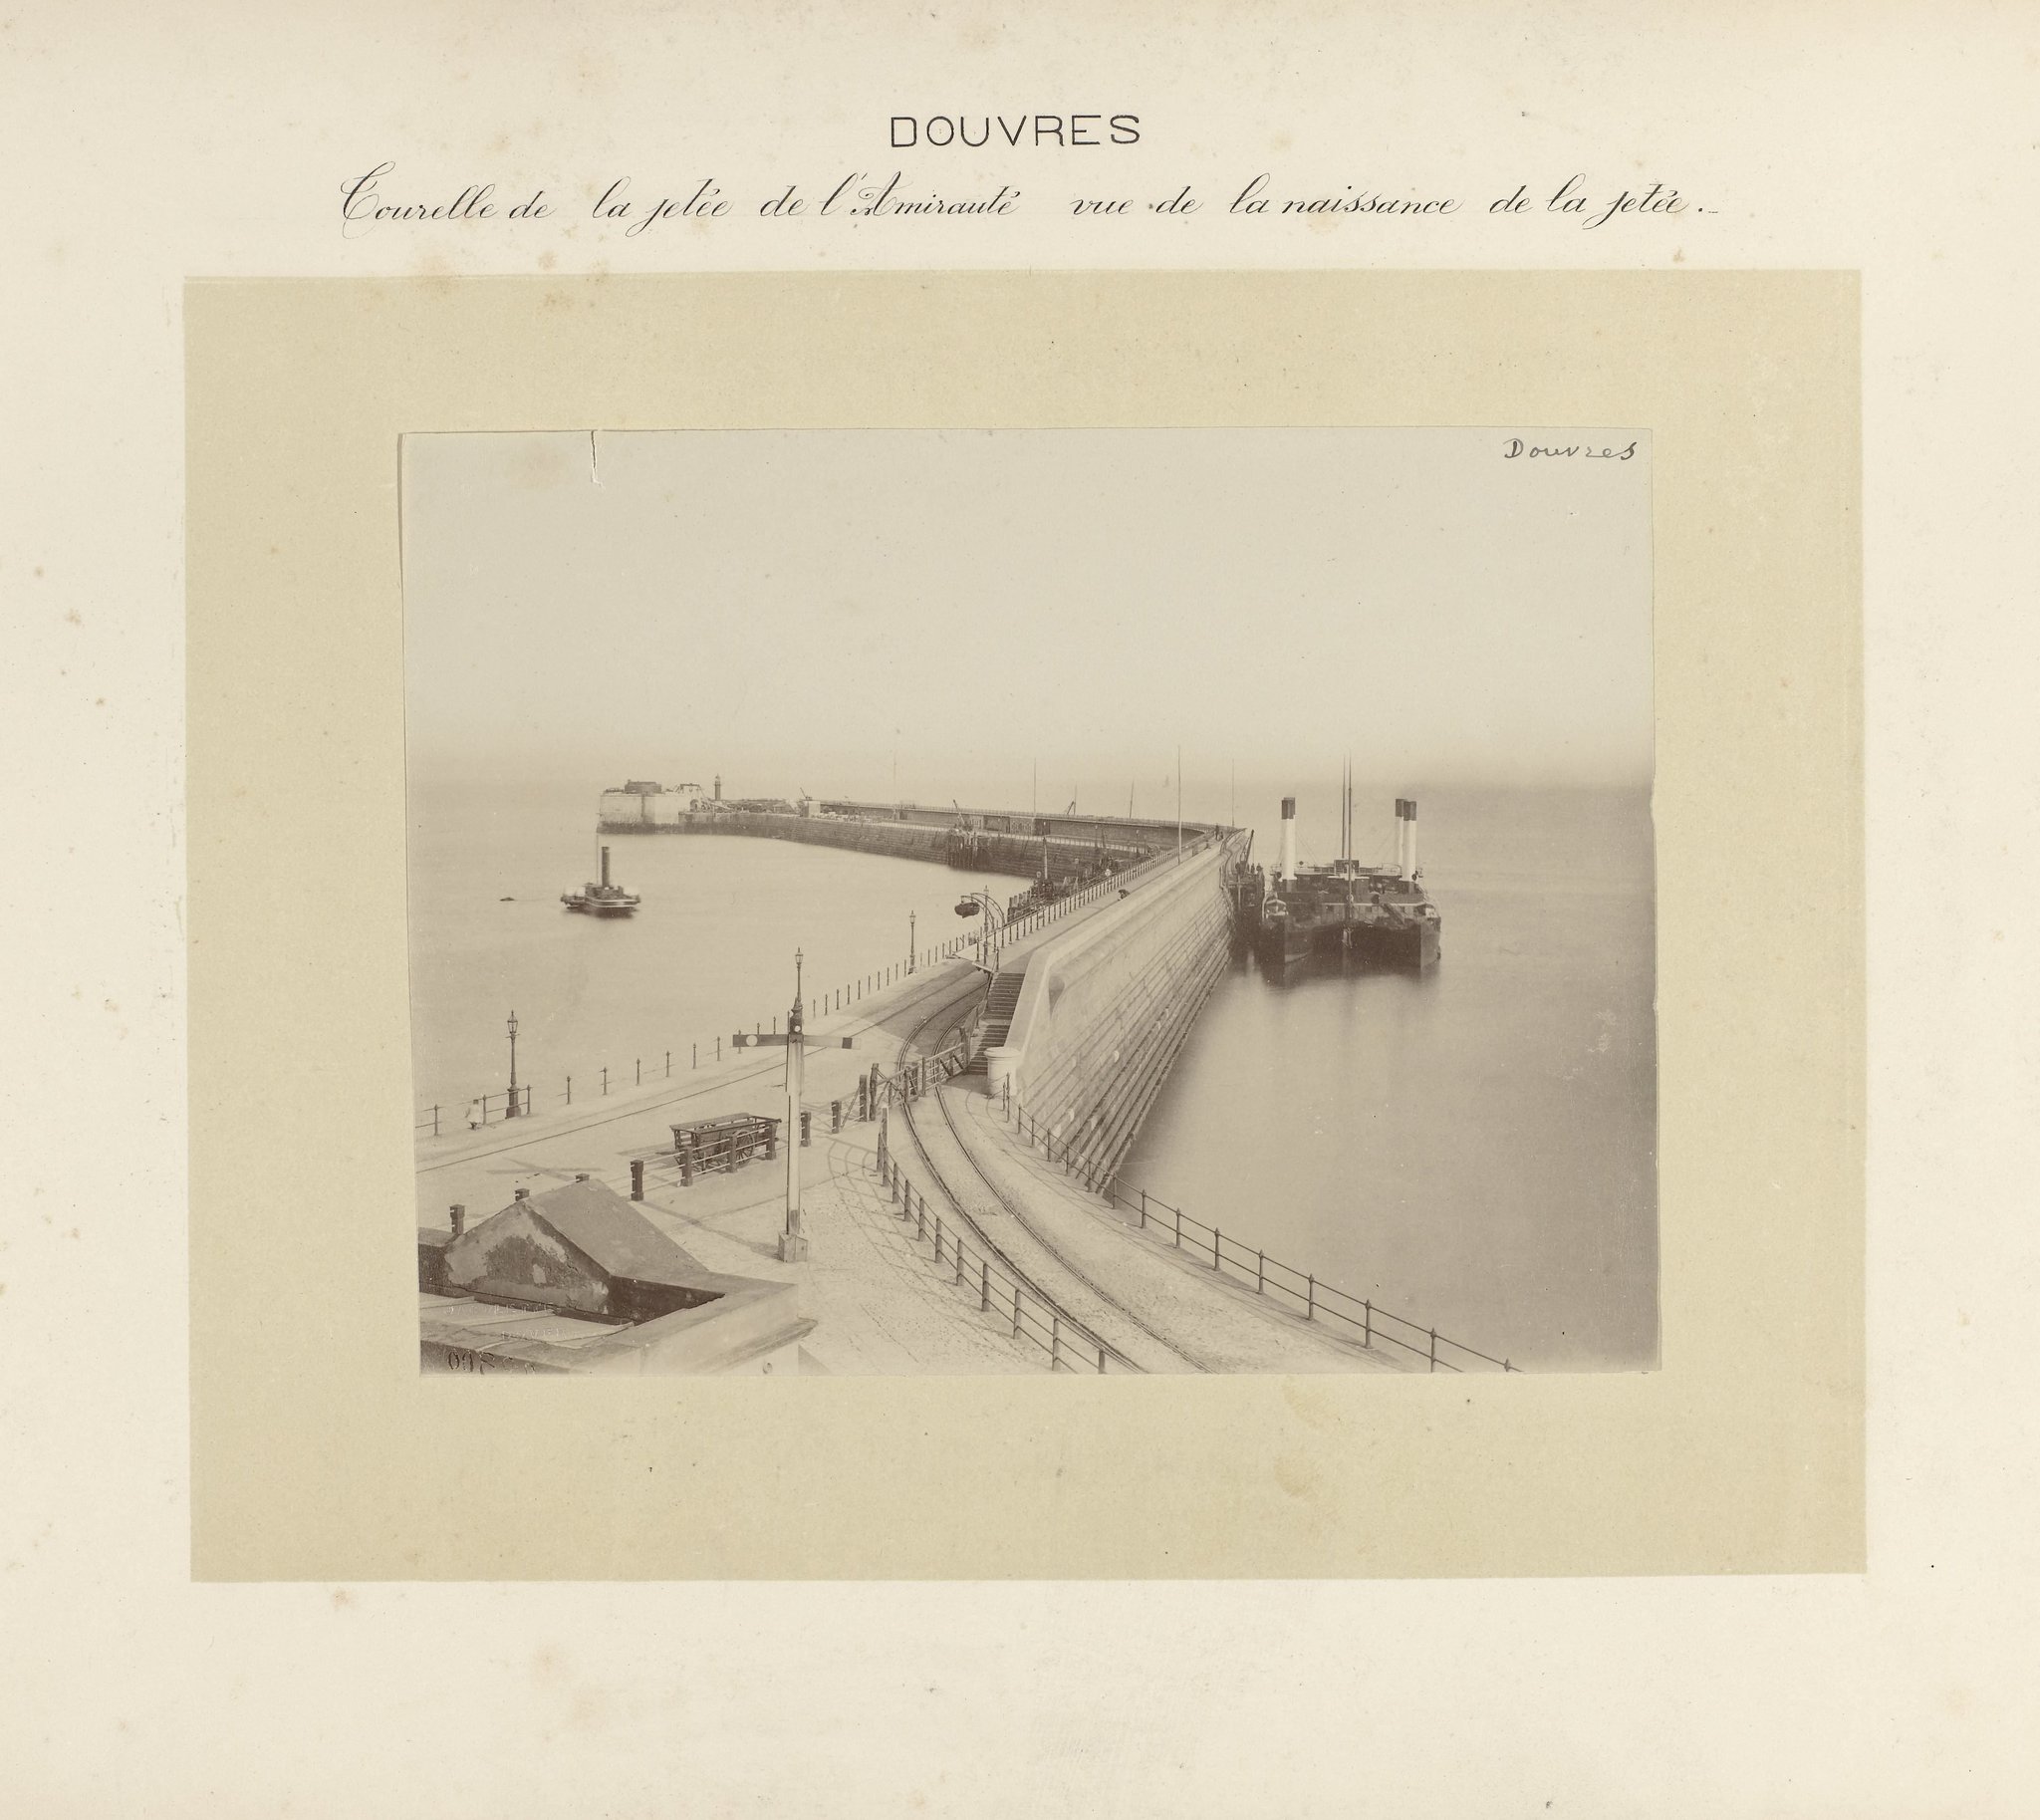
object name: photograph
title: Gezicht op de dam in de haven van Dover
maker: jacolette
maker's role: fotograaf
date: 1891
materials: cardboard, paper, photographic support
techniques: albumen print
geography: great britain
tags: harbour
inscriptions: check stamp: ‘JACOLETTE, / DOVER’, inscription: ‘DOUVRES / Courelle de la jetée de l'Admirauté vue de la naisaance de la jetée’, inscription: ‘Douvres’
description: Foto uit een album met 35 topografische foto's van Britse kustplaatsen, waarop in pen militaire verdedigingswerken zijn aangegeven door een Franse militair.